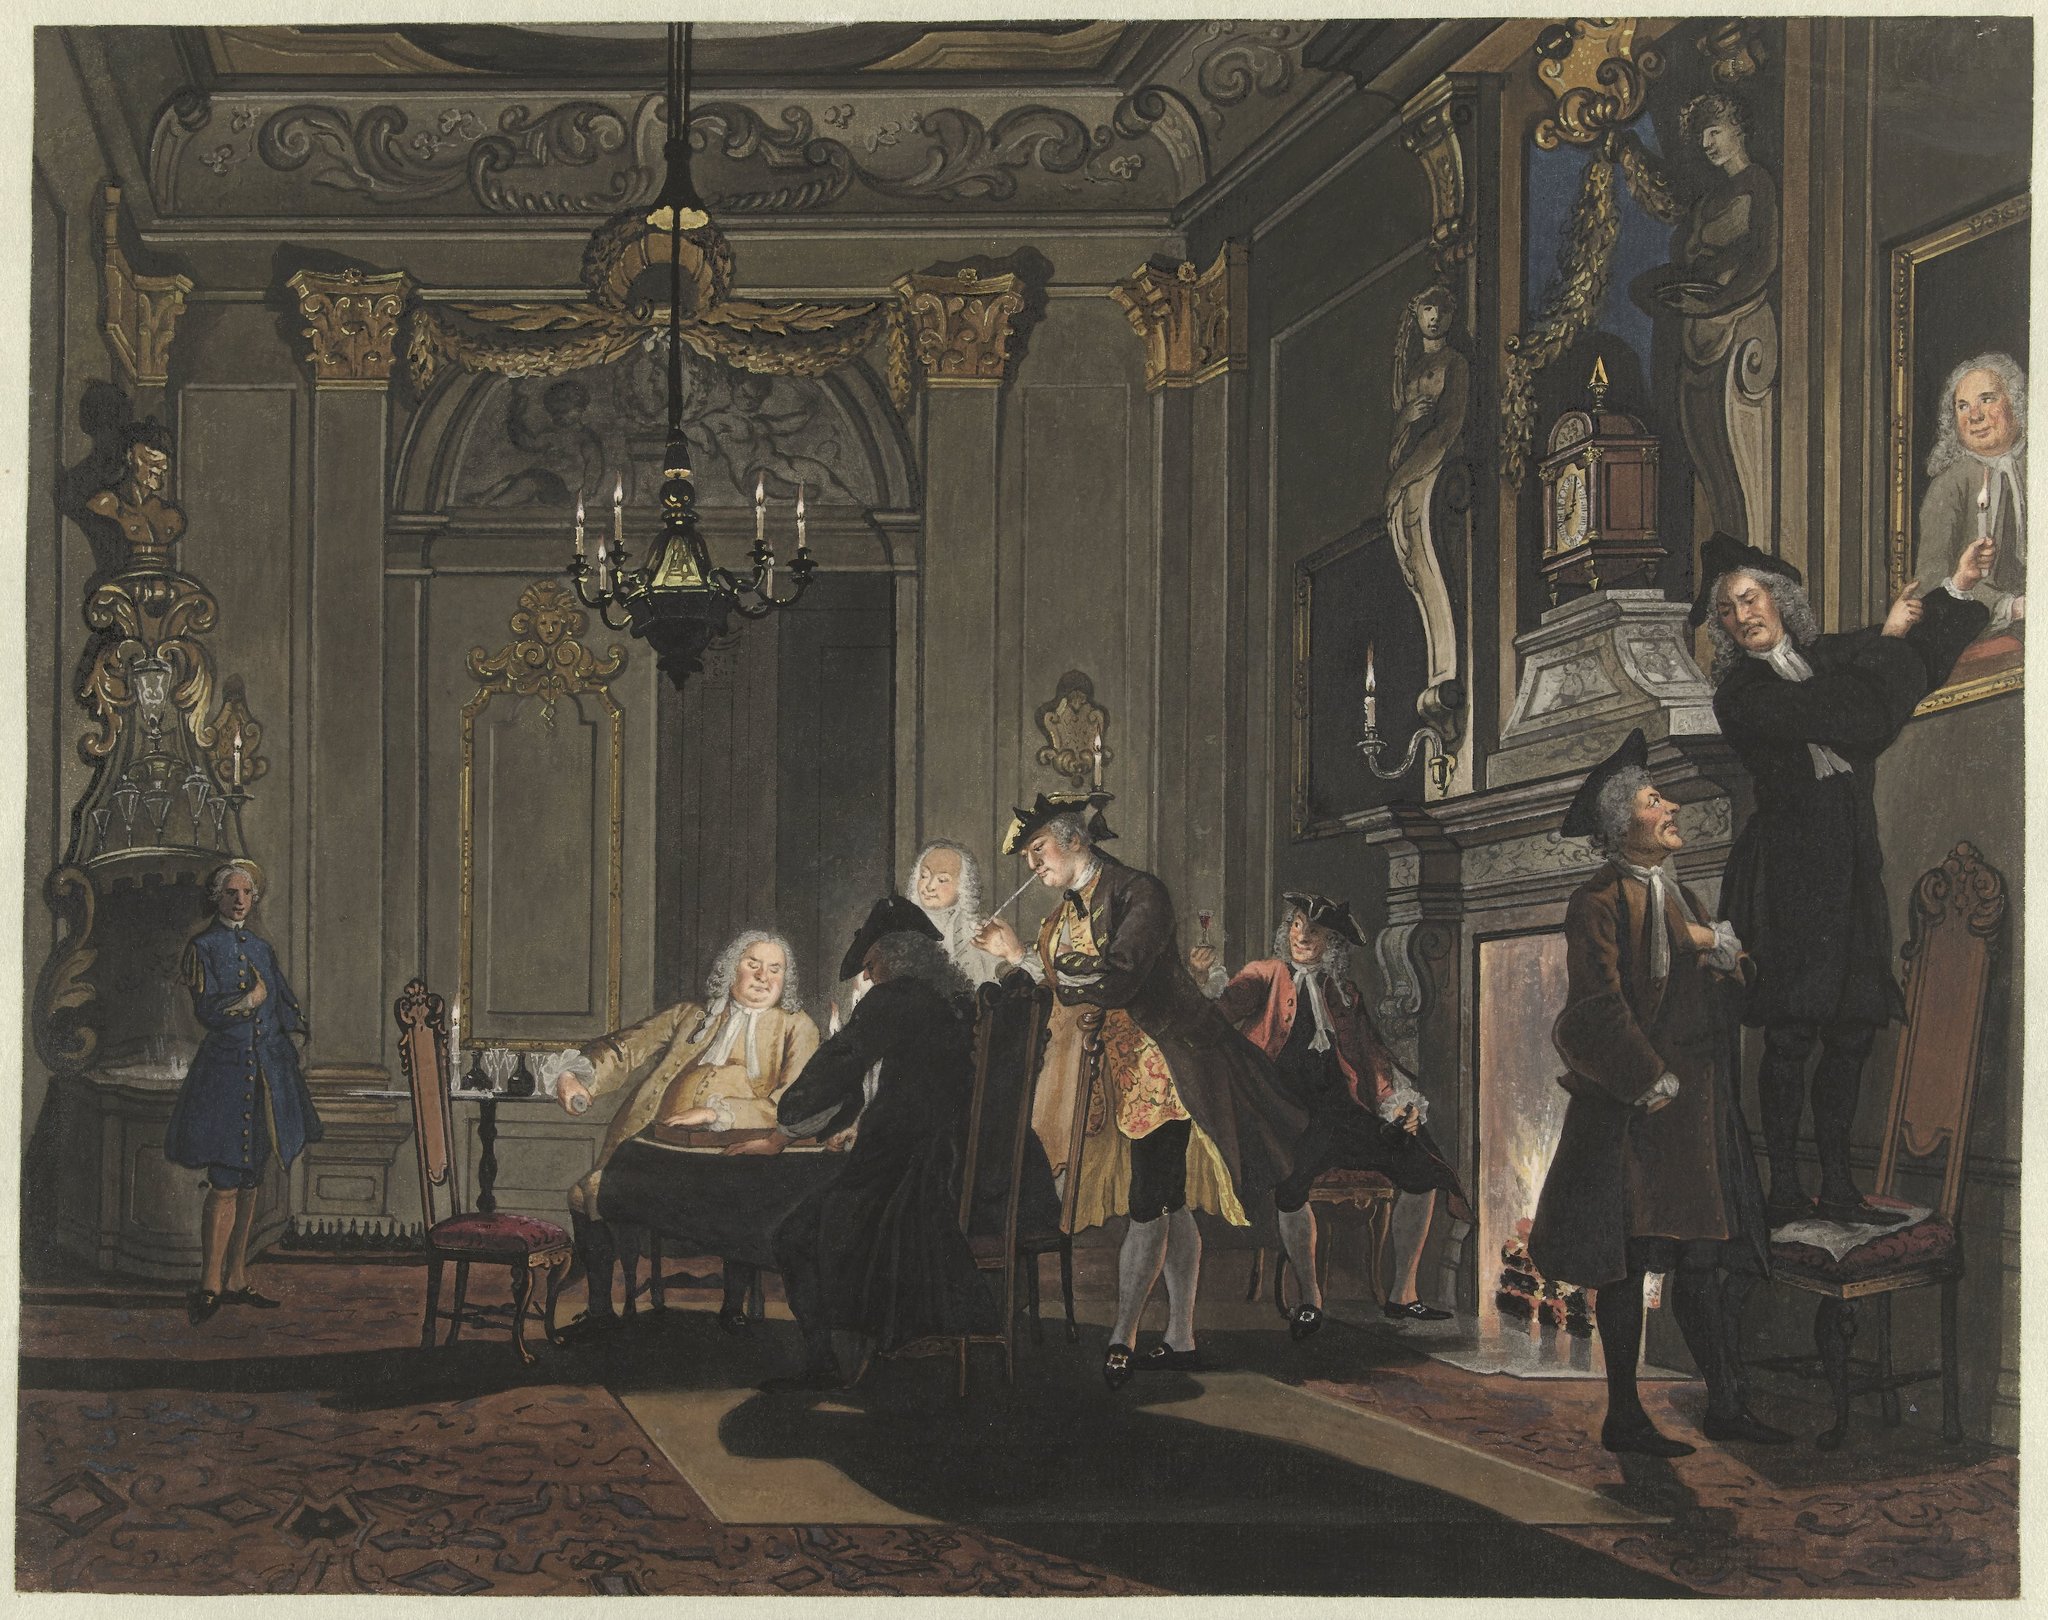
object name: drawing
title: The Brothers Were Having a Conversation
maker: sara troost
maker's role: draughtsman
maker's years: 1732-1803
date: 1769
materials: paint, paper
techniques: brush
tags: private festivities, merry company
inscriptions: inscription: ‘C Troost Pinx / Sara Troost del’, annotation: ‘ERAT SERMO INTER FRATRES. / In hetzelve vertrek zijn 'er twee van 't Gezelschap speelende in 't Verkeerbord (...).’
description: In the second scene, the atmosphere is somewhat more relaxed. Drinks have been poured, and the gentleman seated before the hearth inspects his glass. The trictrac board, a popular game of chance, is in use. In the right foreground, two guests examine a portrait of their host. One of them has boldly climbed onto a chair for a closer look, but not before placing a napkin on the seat.